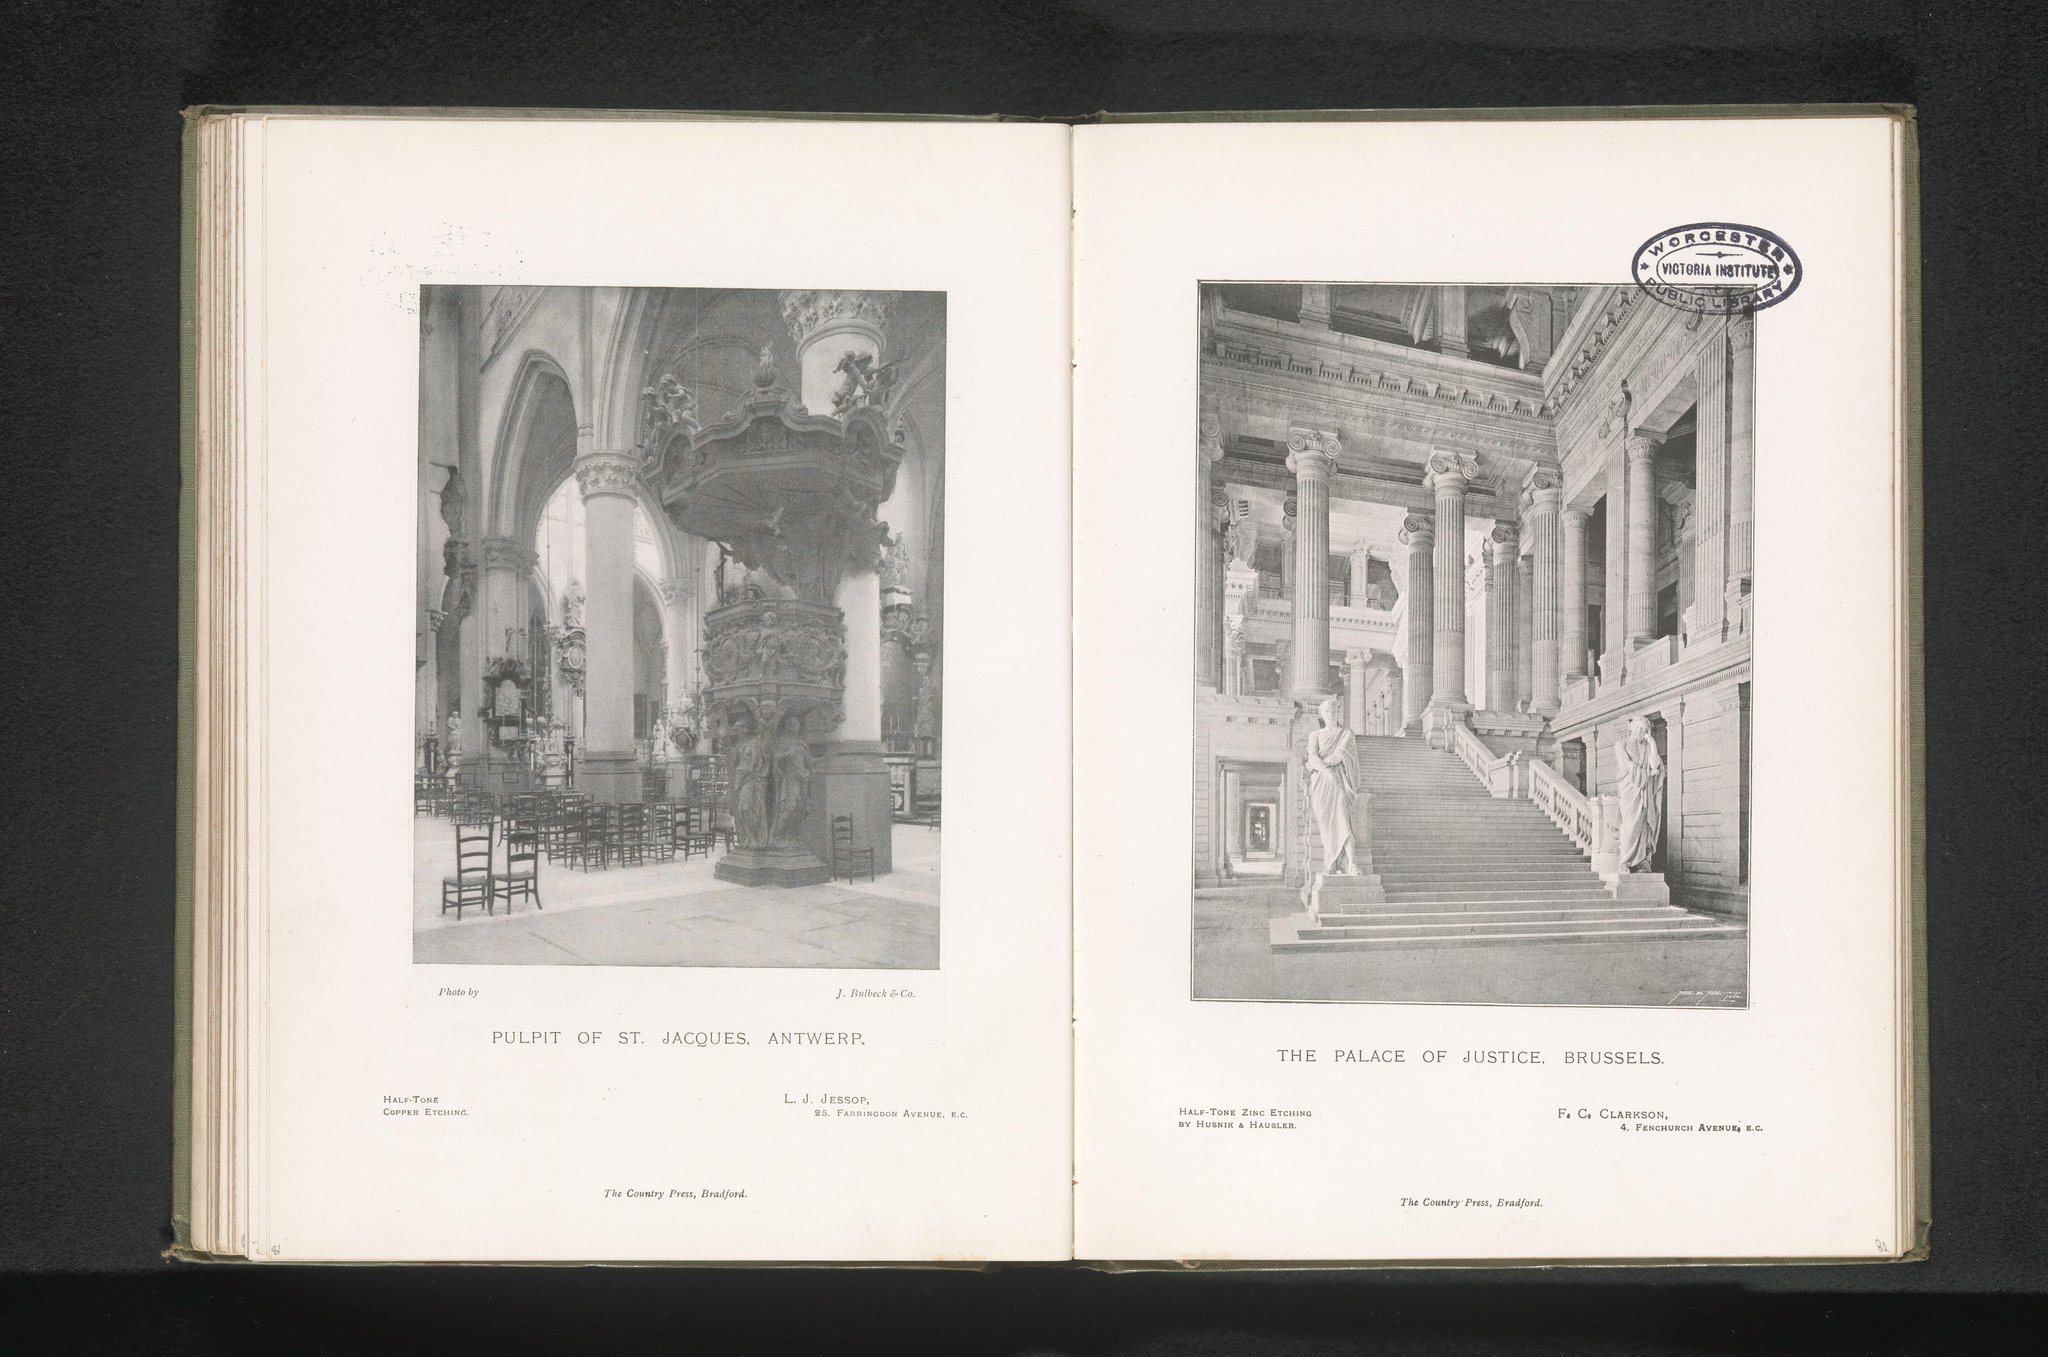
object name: page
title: Interieur van het Justitiepaleis van Brussel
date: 1893-1898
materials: paper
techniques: autotype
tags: court building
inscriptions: collector's mark: ‘Worcester Public Library/ Victoria Institute’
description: Prent op derde ongenummerde pagina na pagina 96.